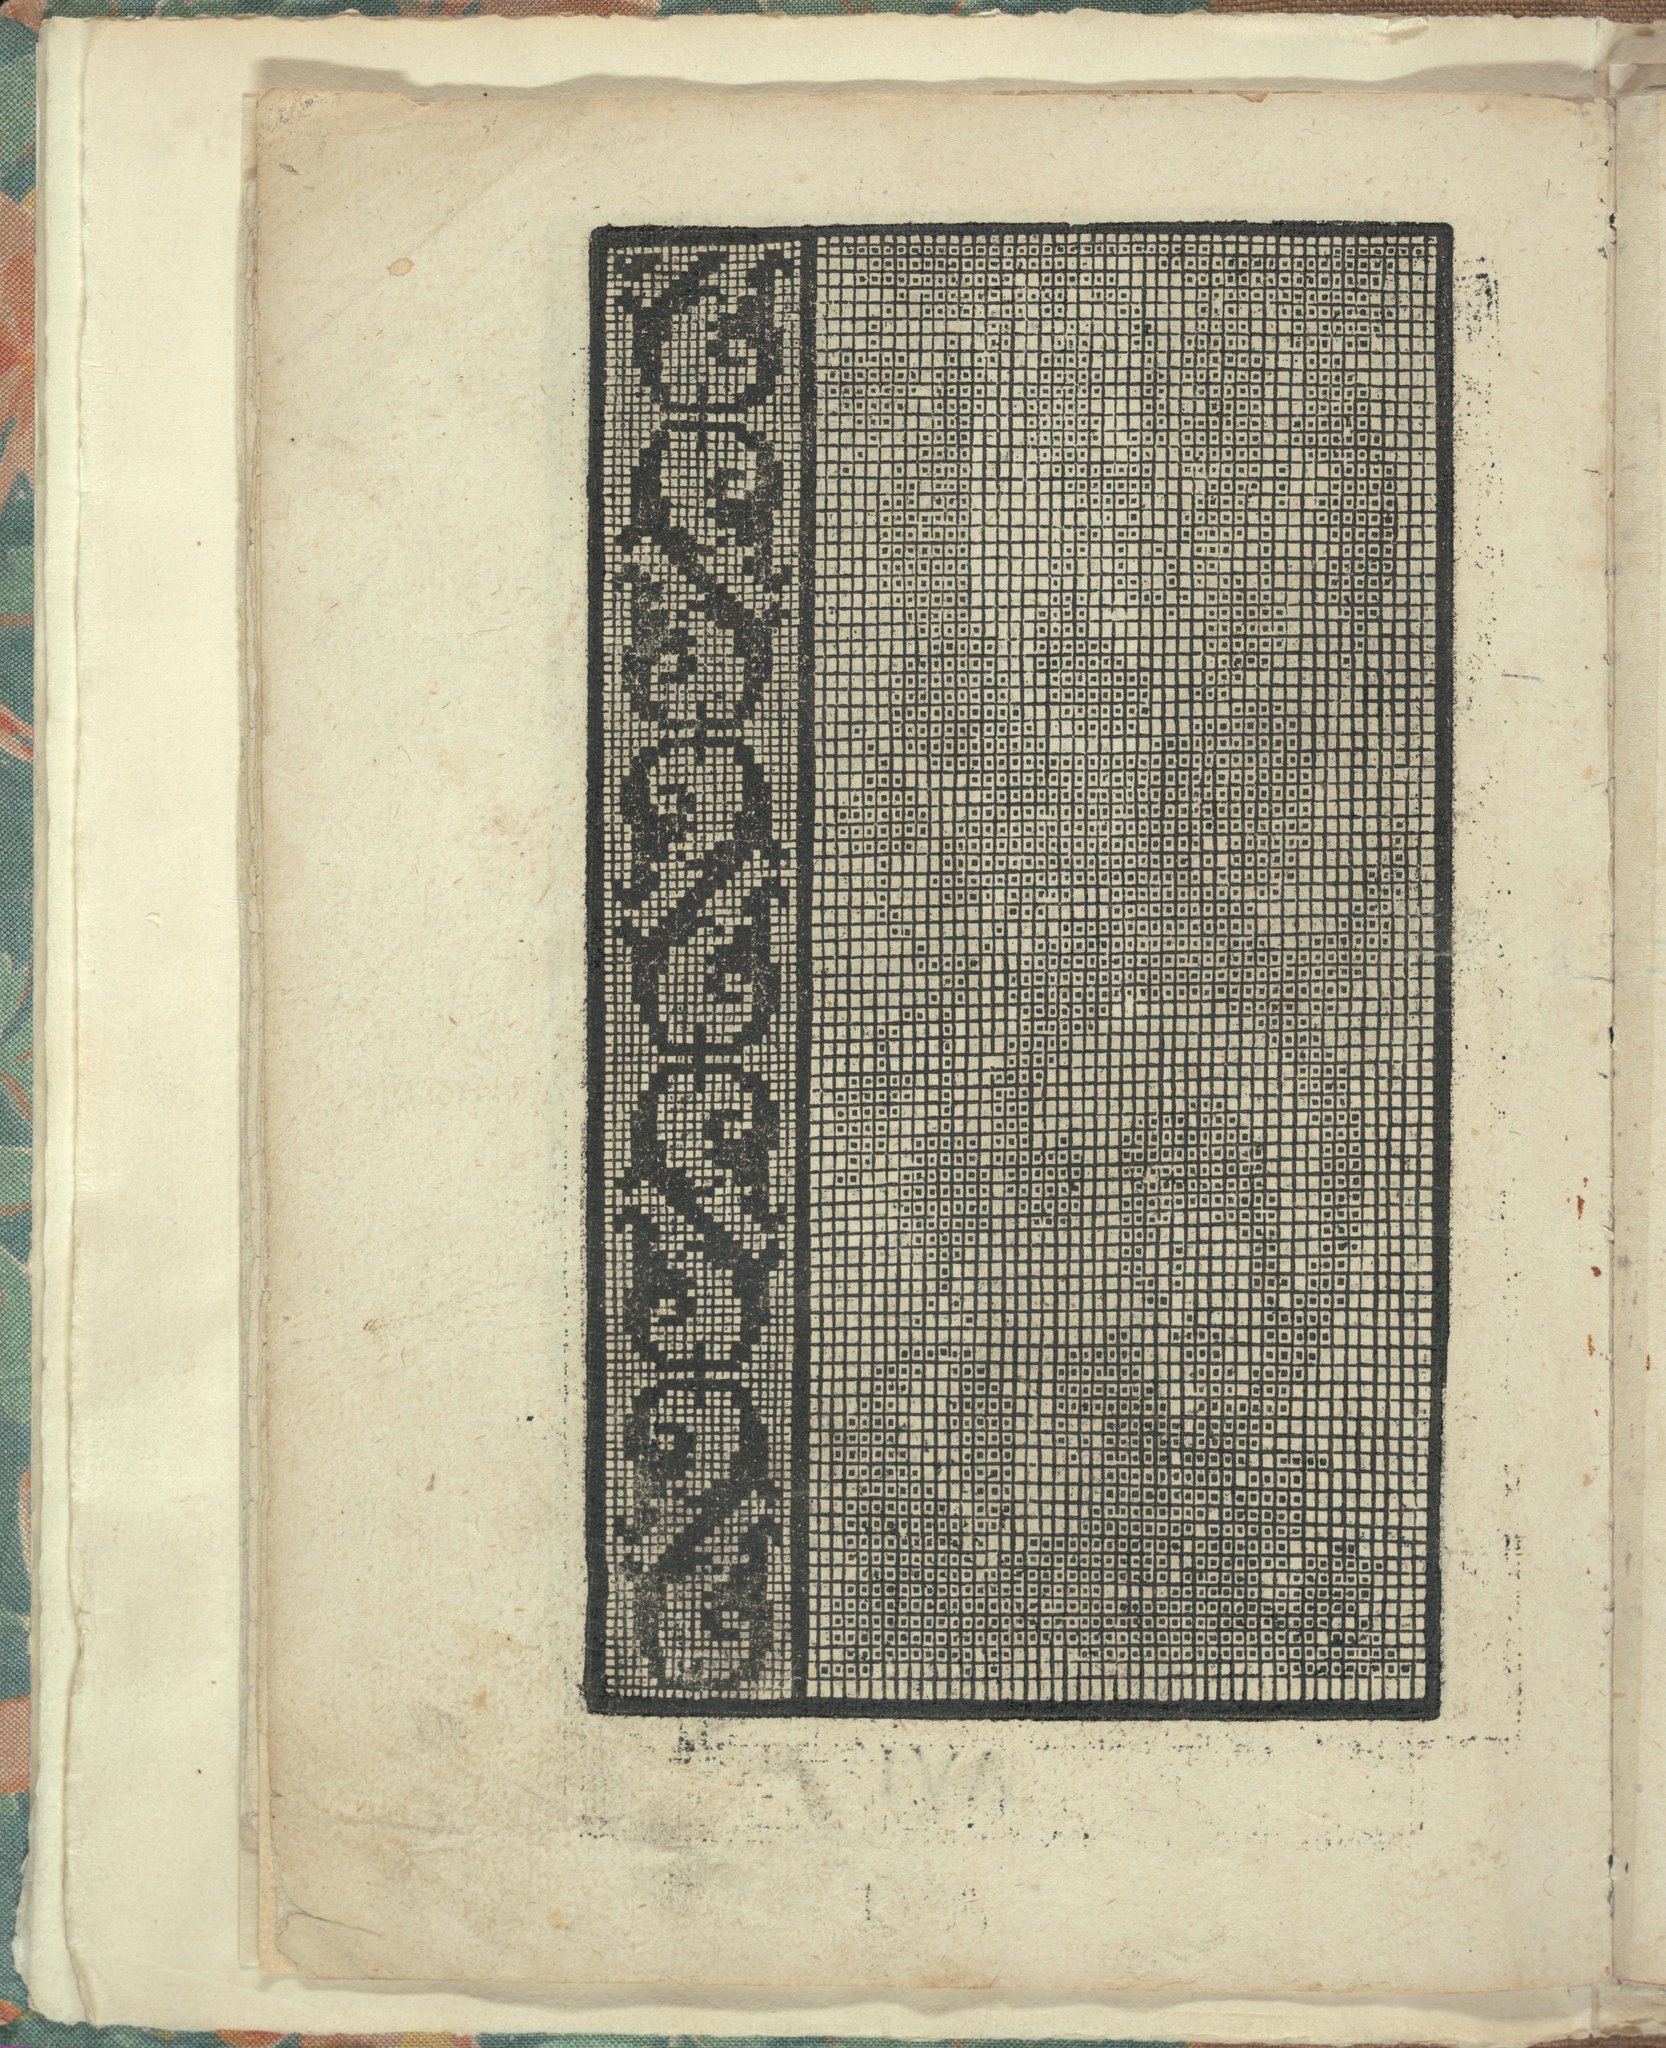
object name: book print ornament architecture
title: Opera Nova Universali intitulata Corona di racammi, page 6 (verso)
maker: giovanni andrea vavassore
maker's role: publisher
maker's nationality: italian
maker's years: 1530-1573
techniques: woodcut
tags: leaves